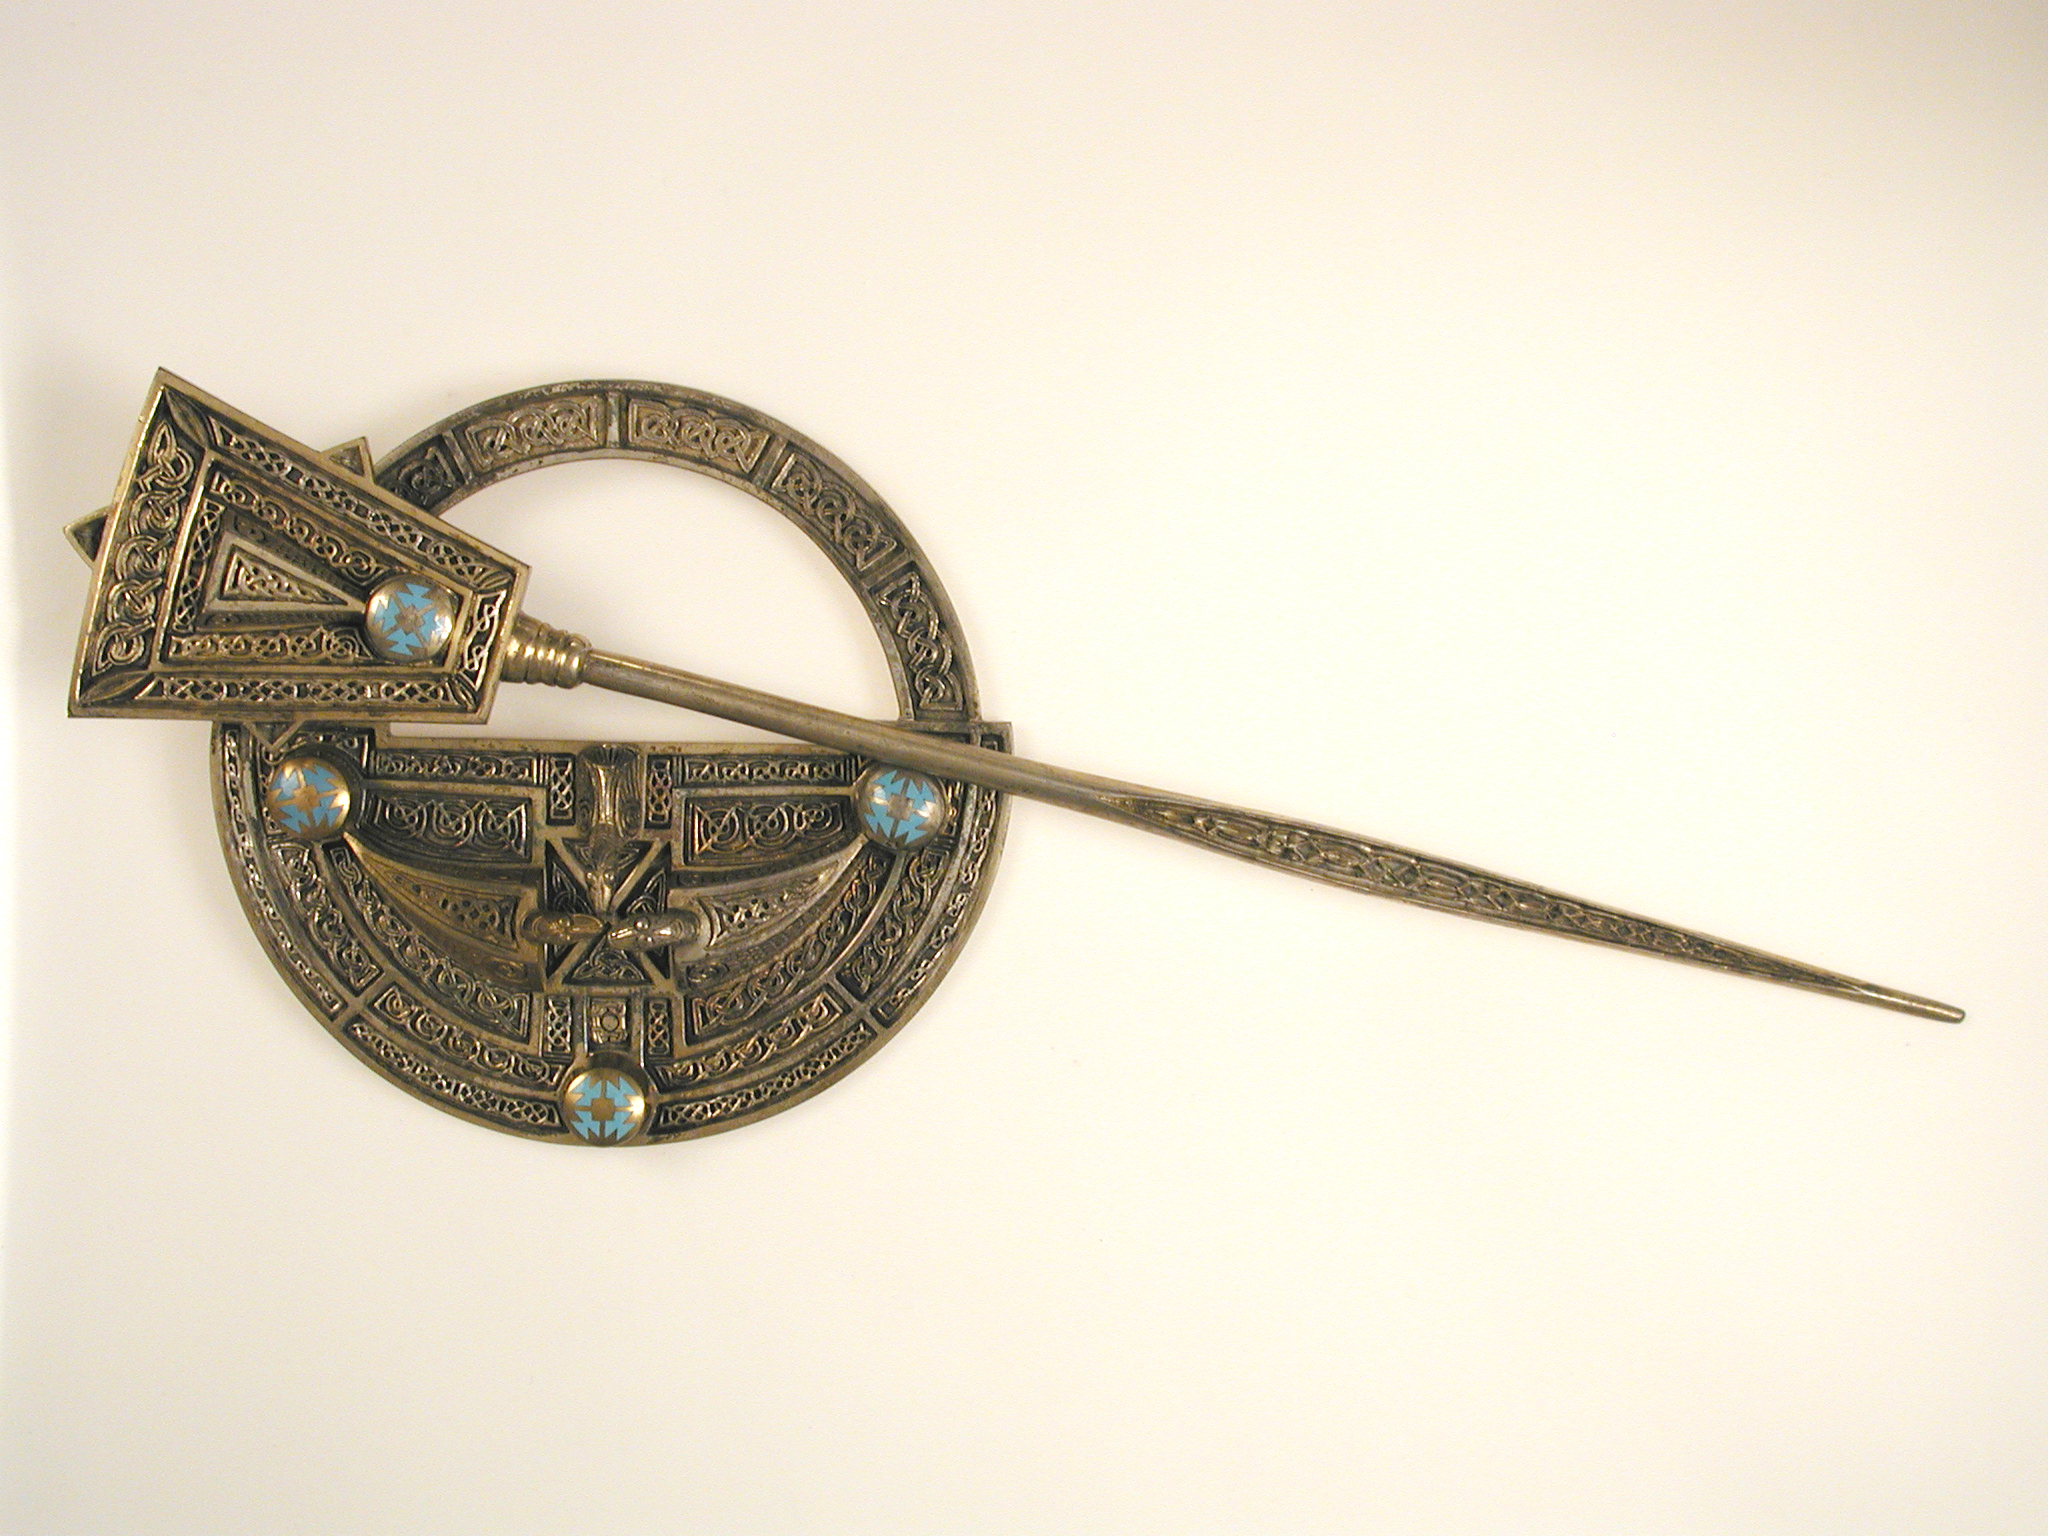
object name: brooch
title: Ardagh Brooch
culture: irish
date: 1901-1933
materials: bronze, gilt